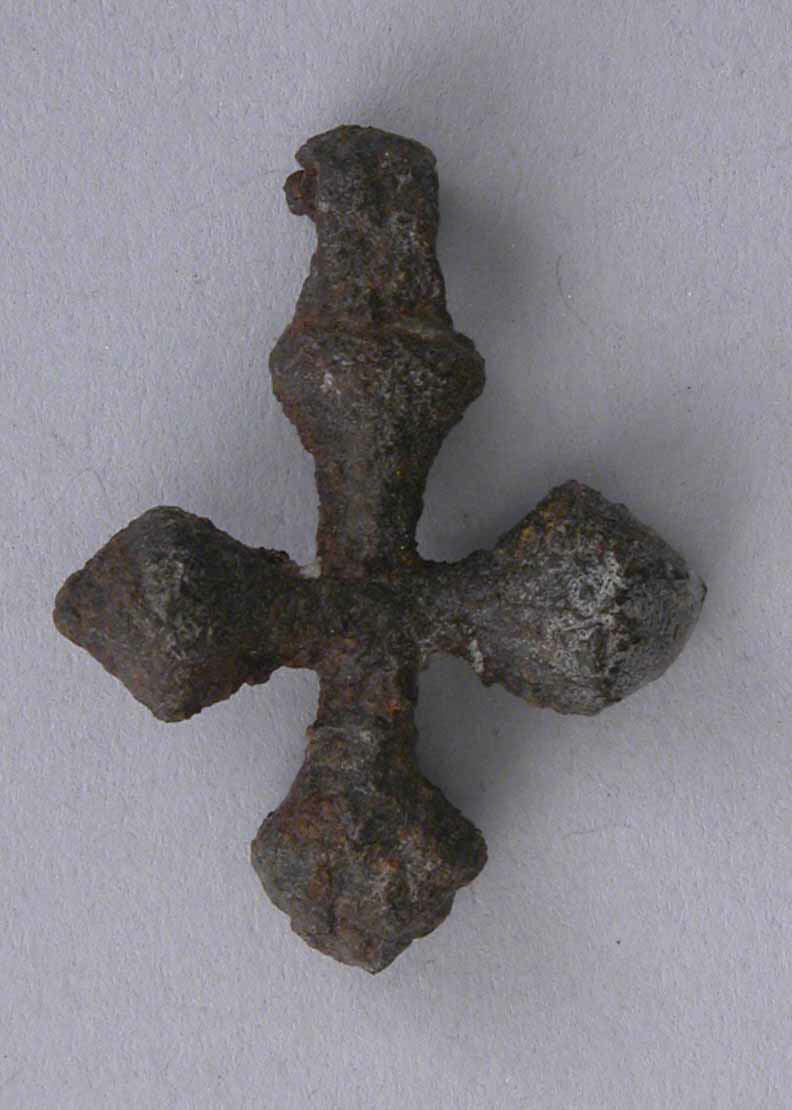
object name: cross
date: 201-1200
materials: iron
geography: egypt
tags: cross